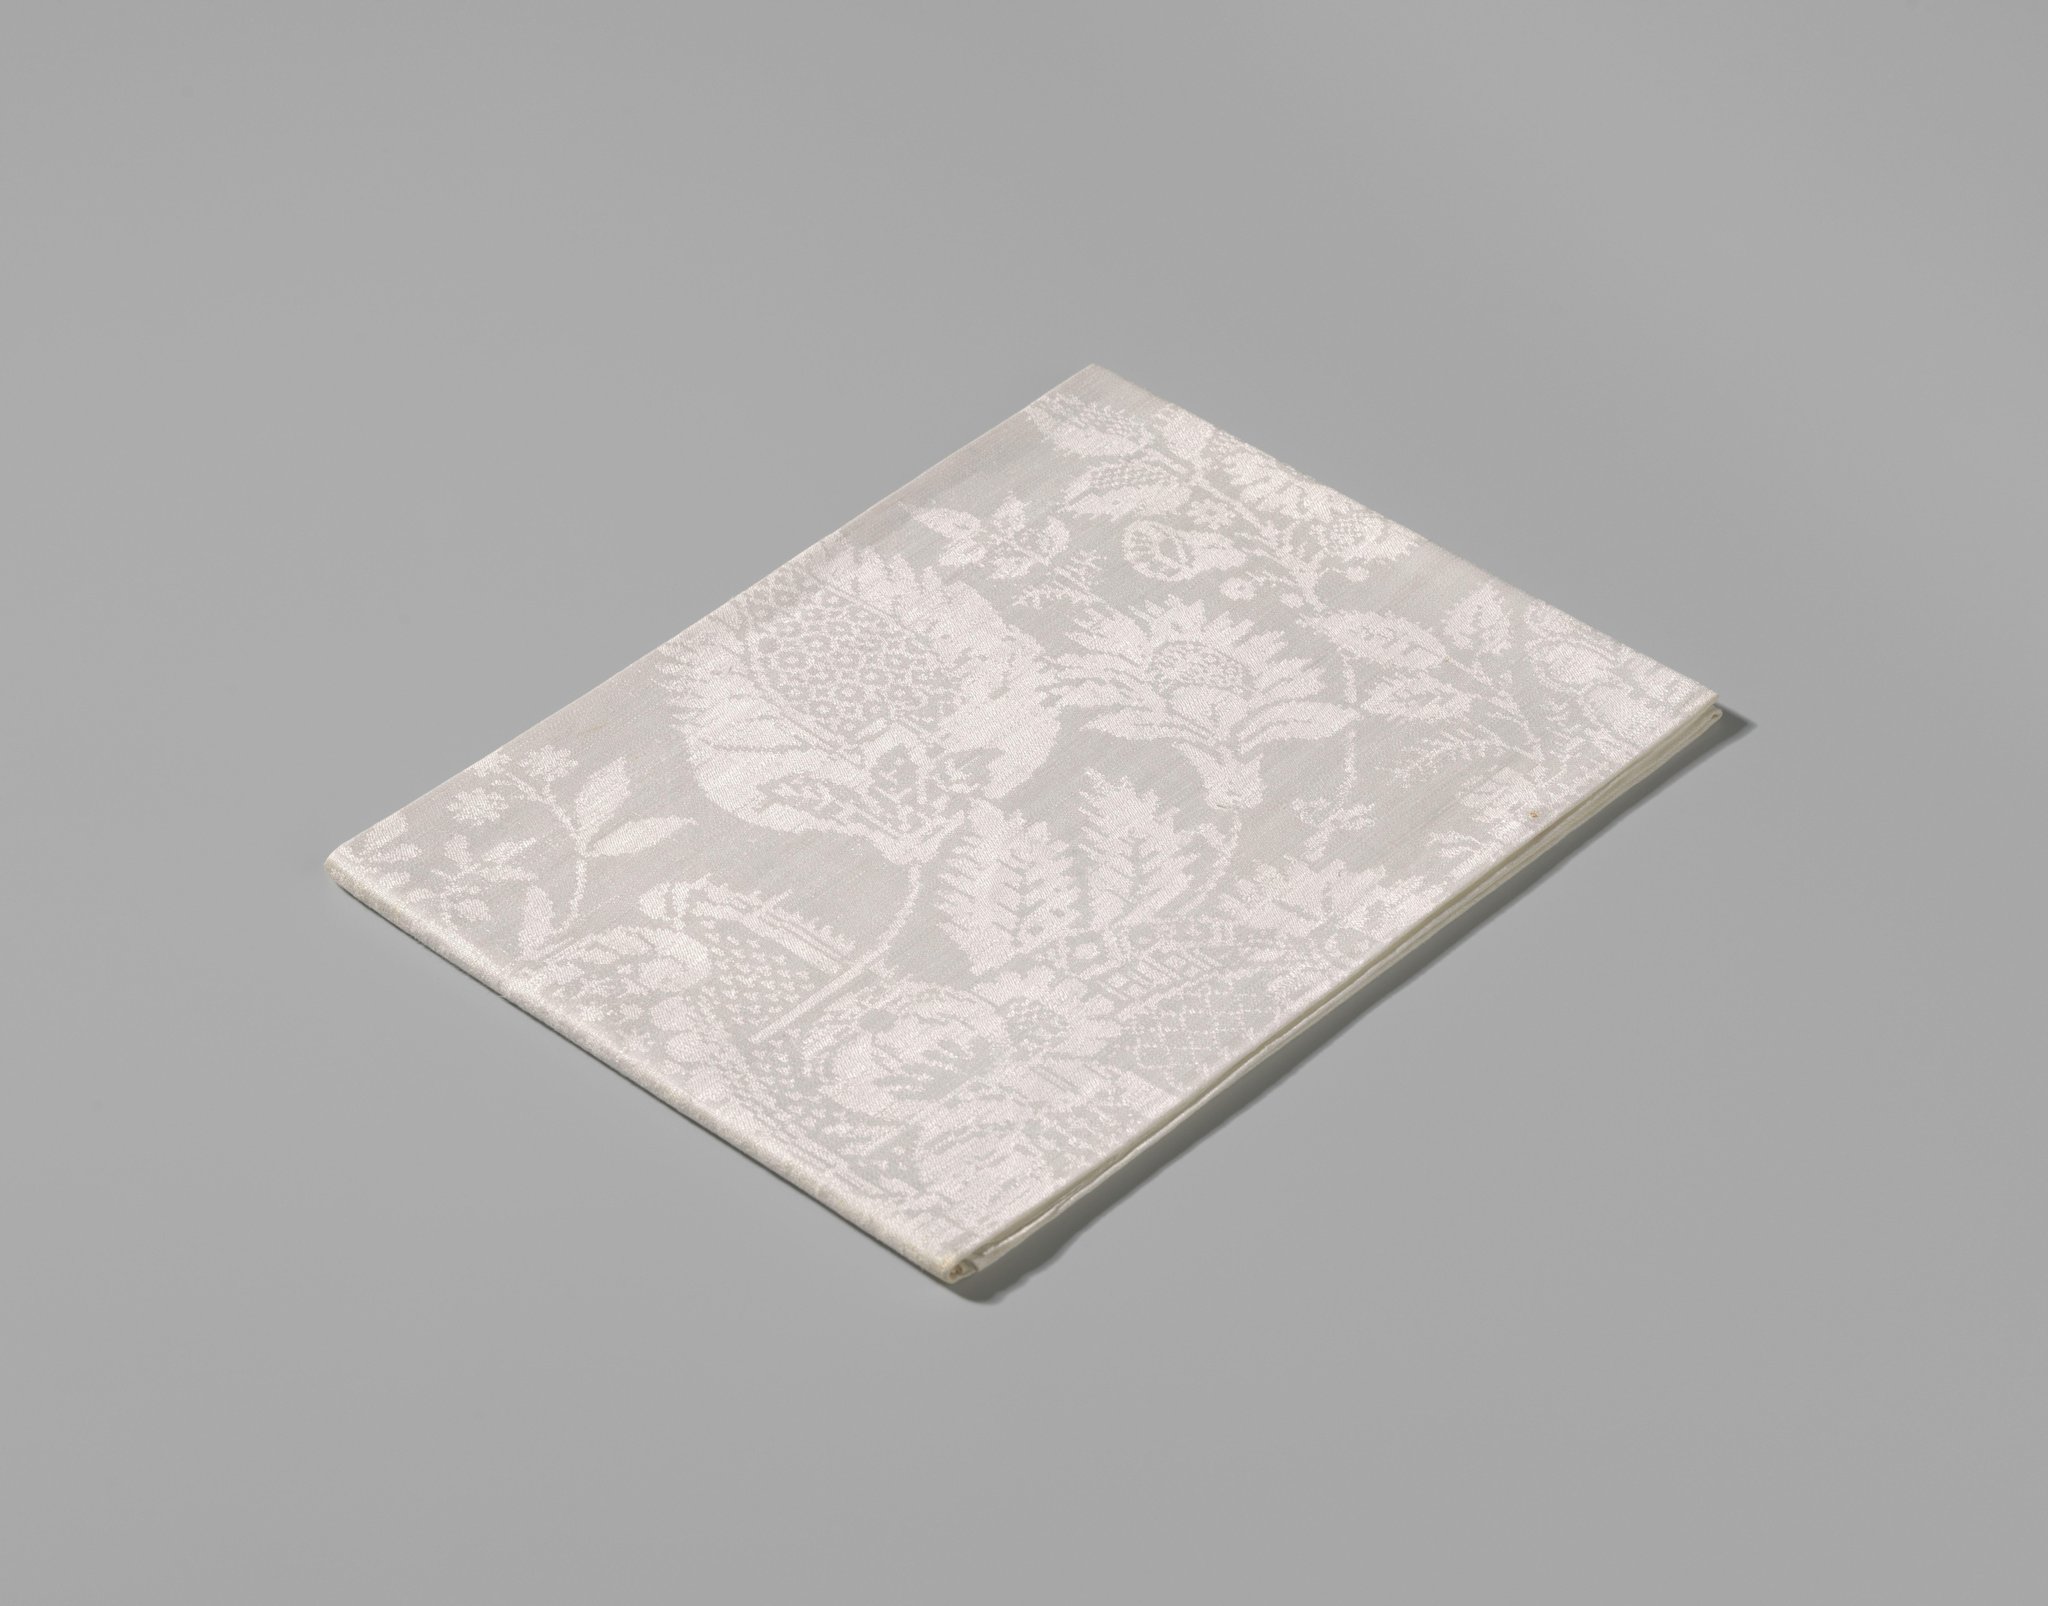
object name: napkin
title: Servet van linnendamast met een kantpatroon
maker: Anonymous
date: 1736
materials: linen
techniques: damask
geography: southern netherlands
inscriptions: date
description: Wit linnendamasten servet, versierd met "kant"-patroon en ingeweven AGT BESIER ANNO 1736 en GHD IORDENS ANNO 1736.